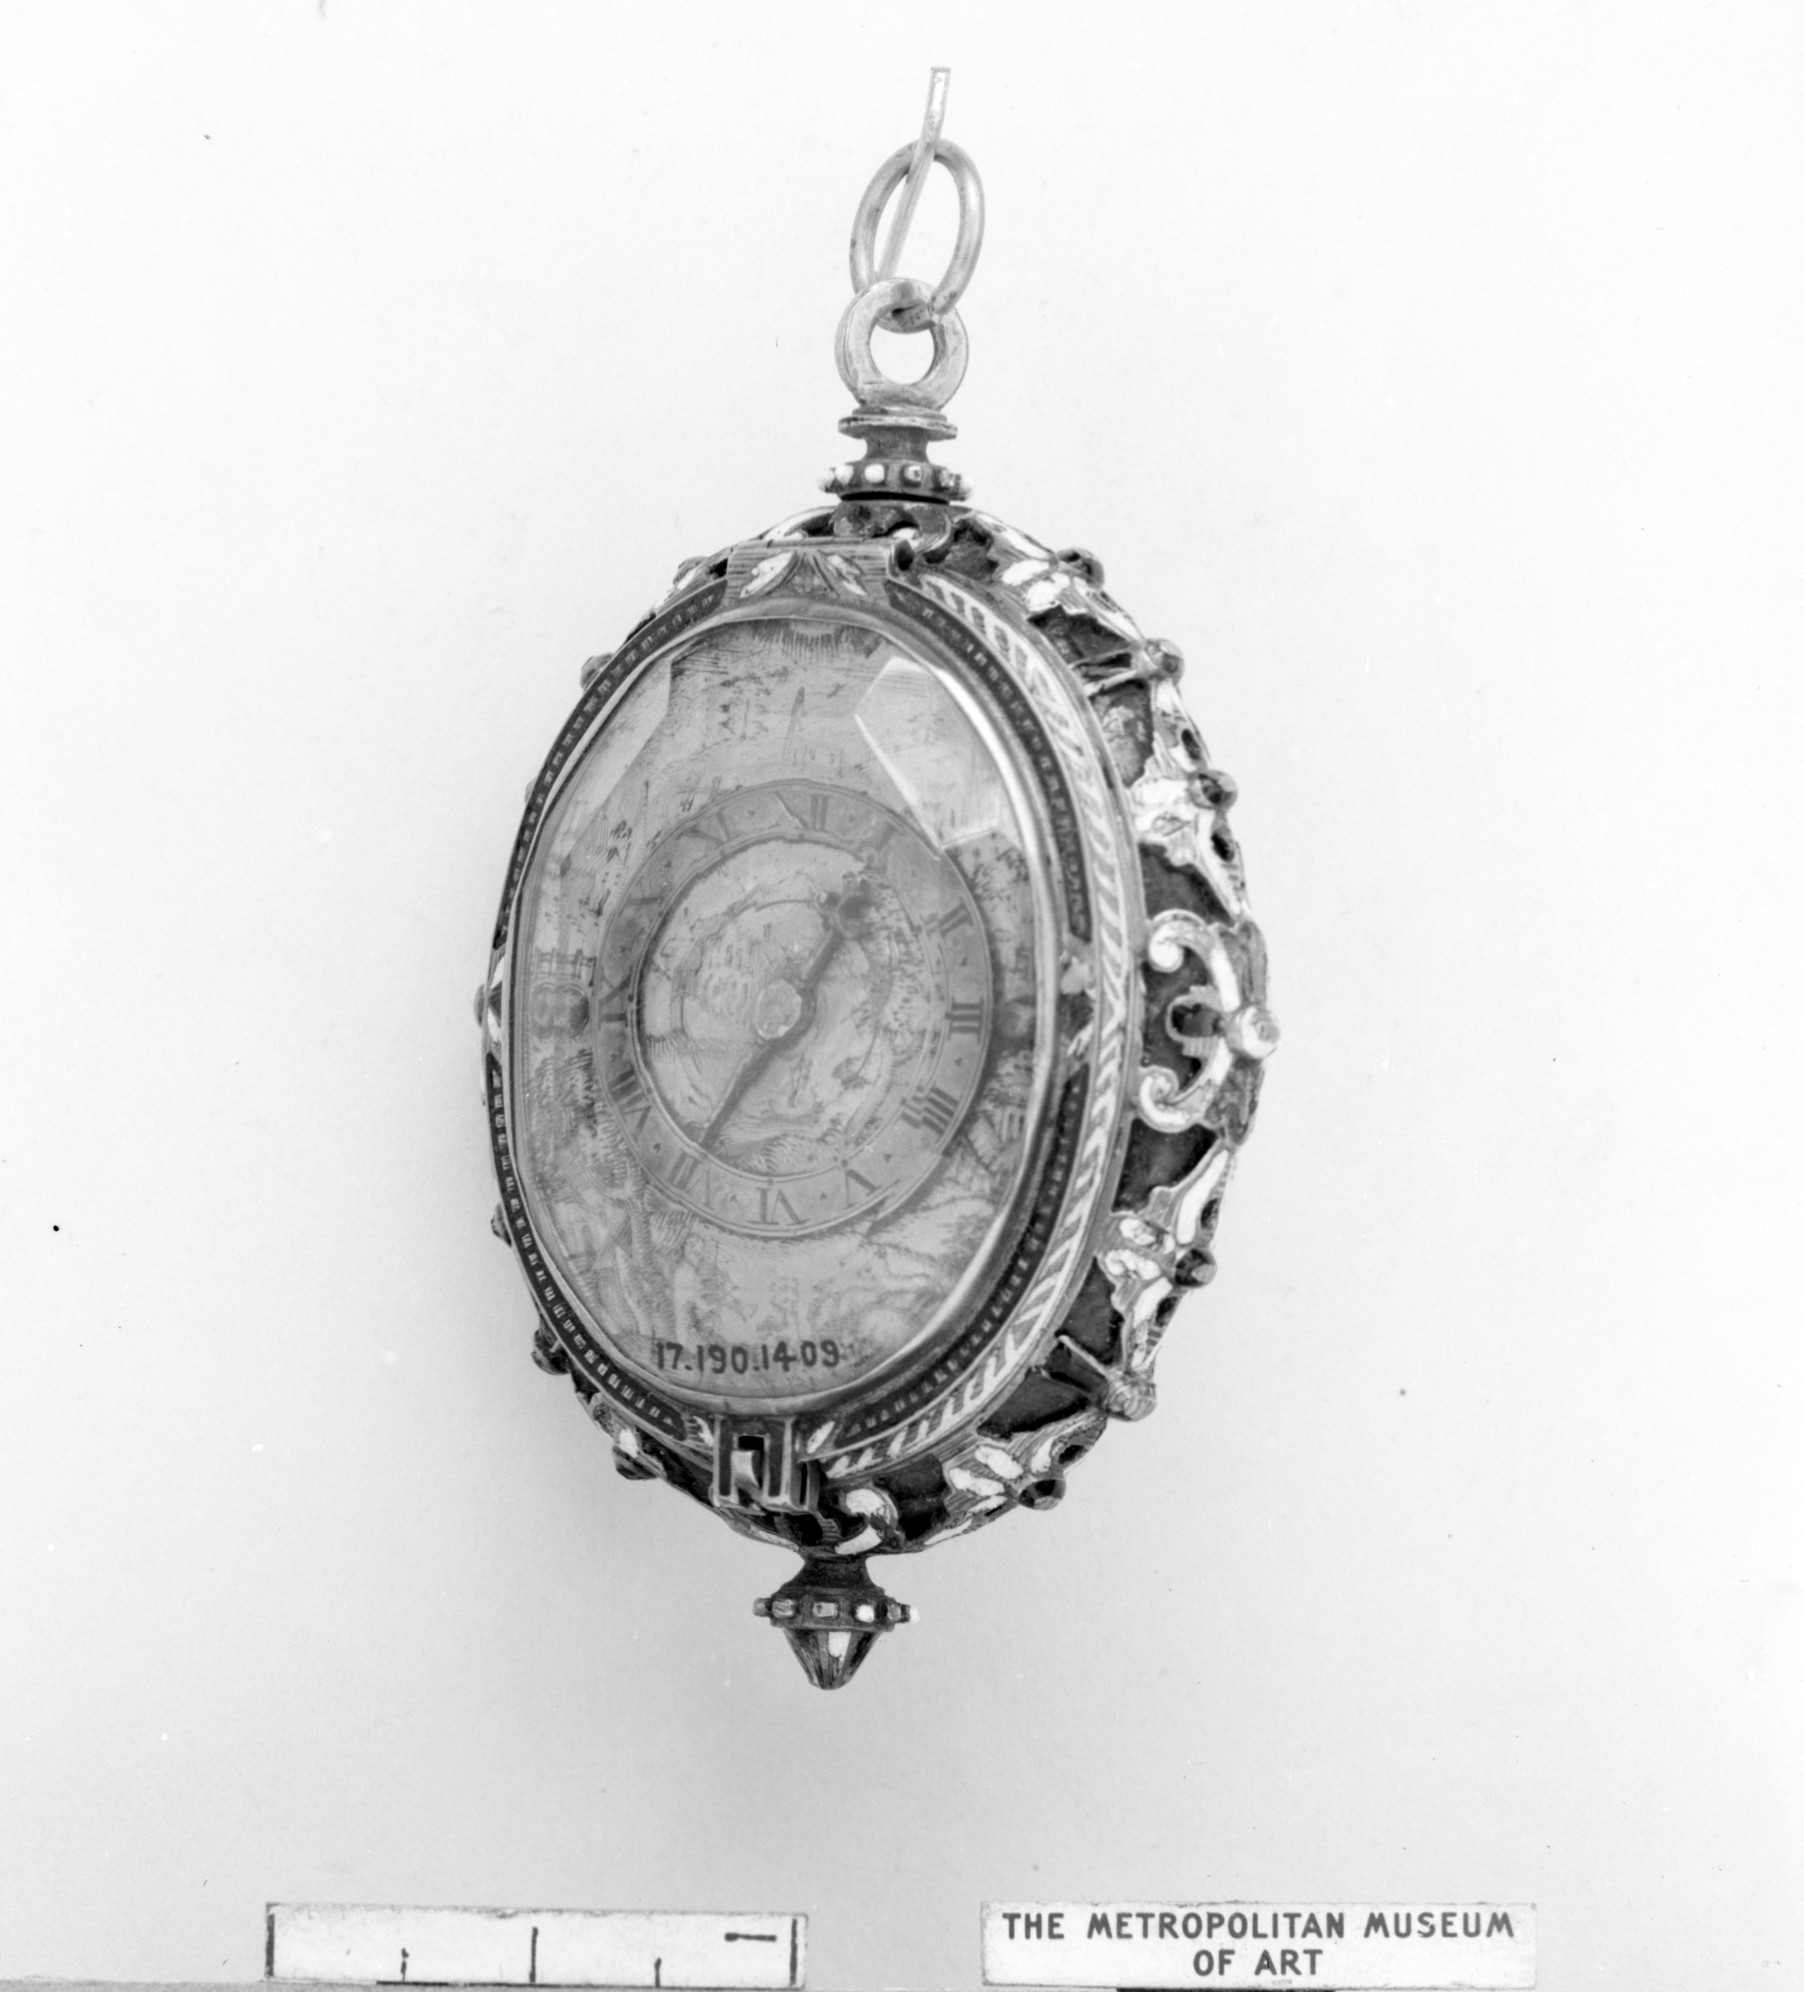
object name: watch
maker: r. dieu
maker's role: maker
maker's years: 1585-1595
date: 1590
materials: gold, quartz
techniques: enamel